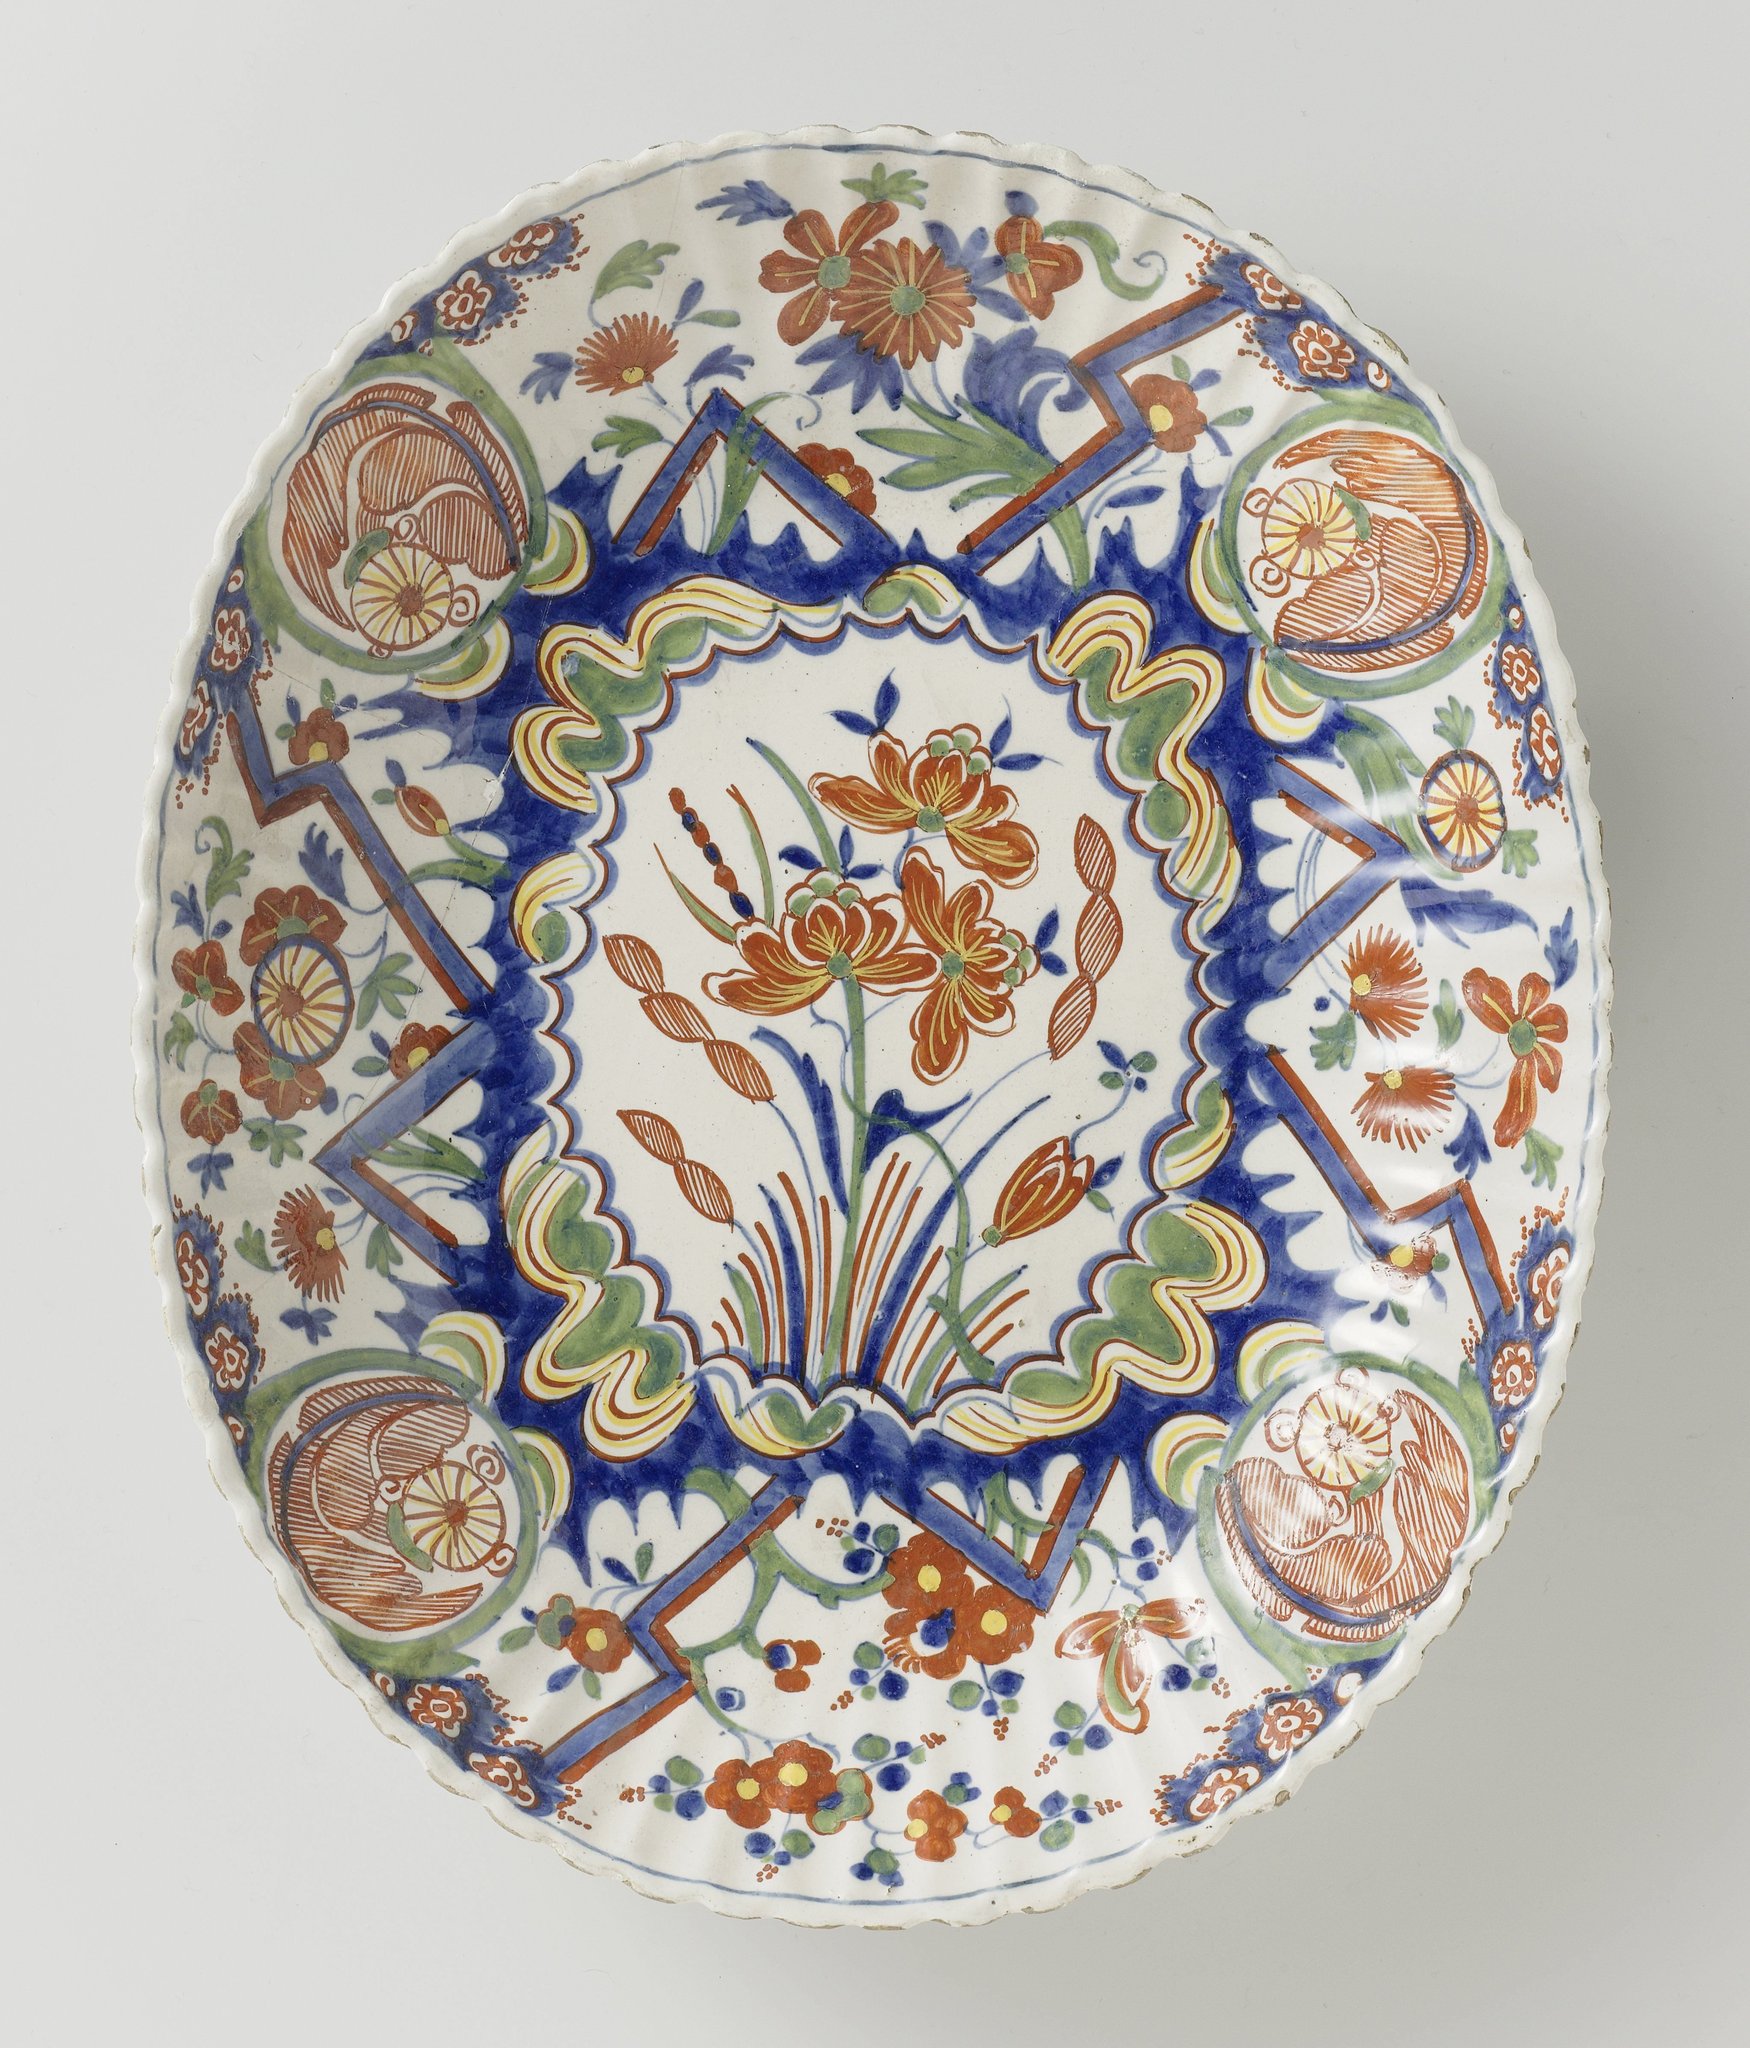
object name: dish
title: schaal met bliksemmotief.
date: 1720-1740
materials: faience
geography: delft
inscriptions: mark: ‘D AUW (ineen)/ kruis’, collector's mark, ond: ‘koninklijk oudheidkundig genootschap no. 4’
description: schaal, ovaal, van faience. Veelkleurig beschilderd met bloemdecoraties en zogenaamd bliksemmotief. Rand gecanneleerd.